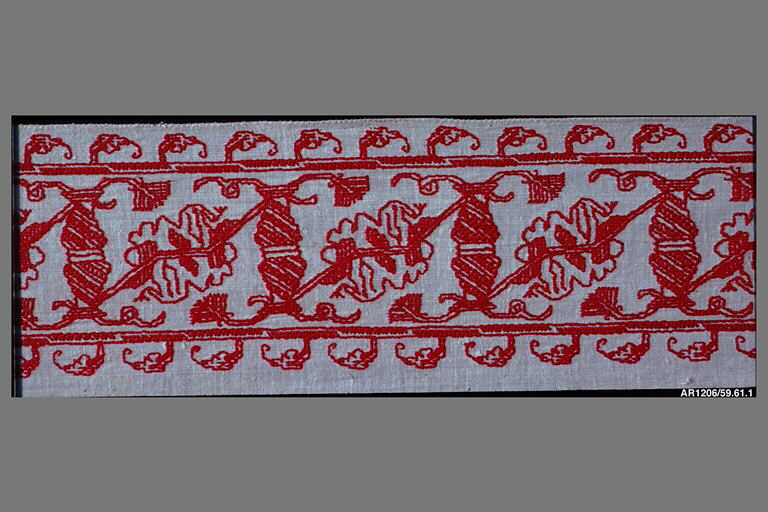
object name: band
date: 1501-1700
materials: linen, silk